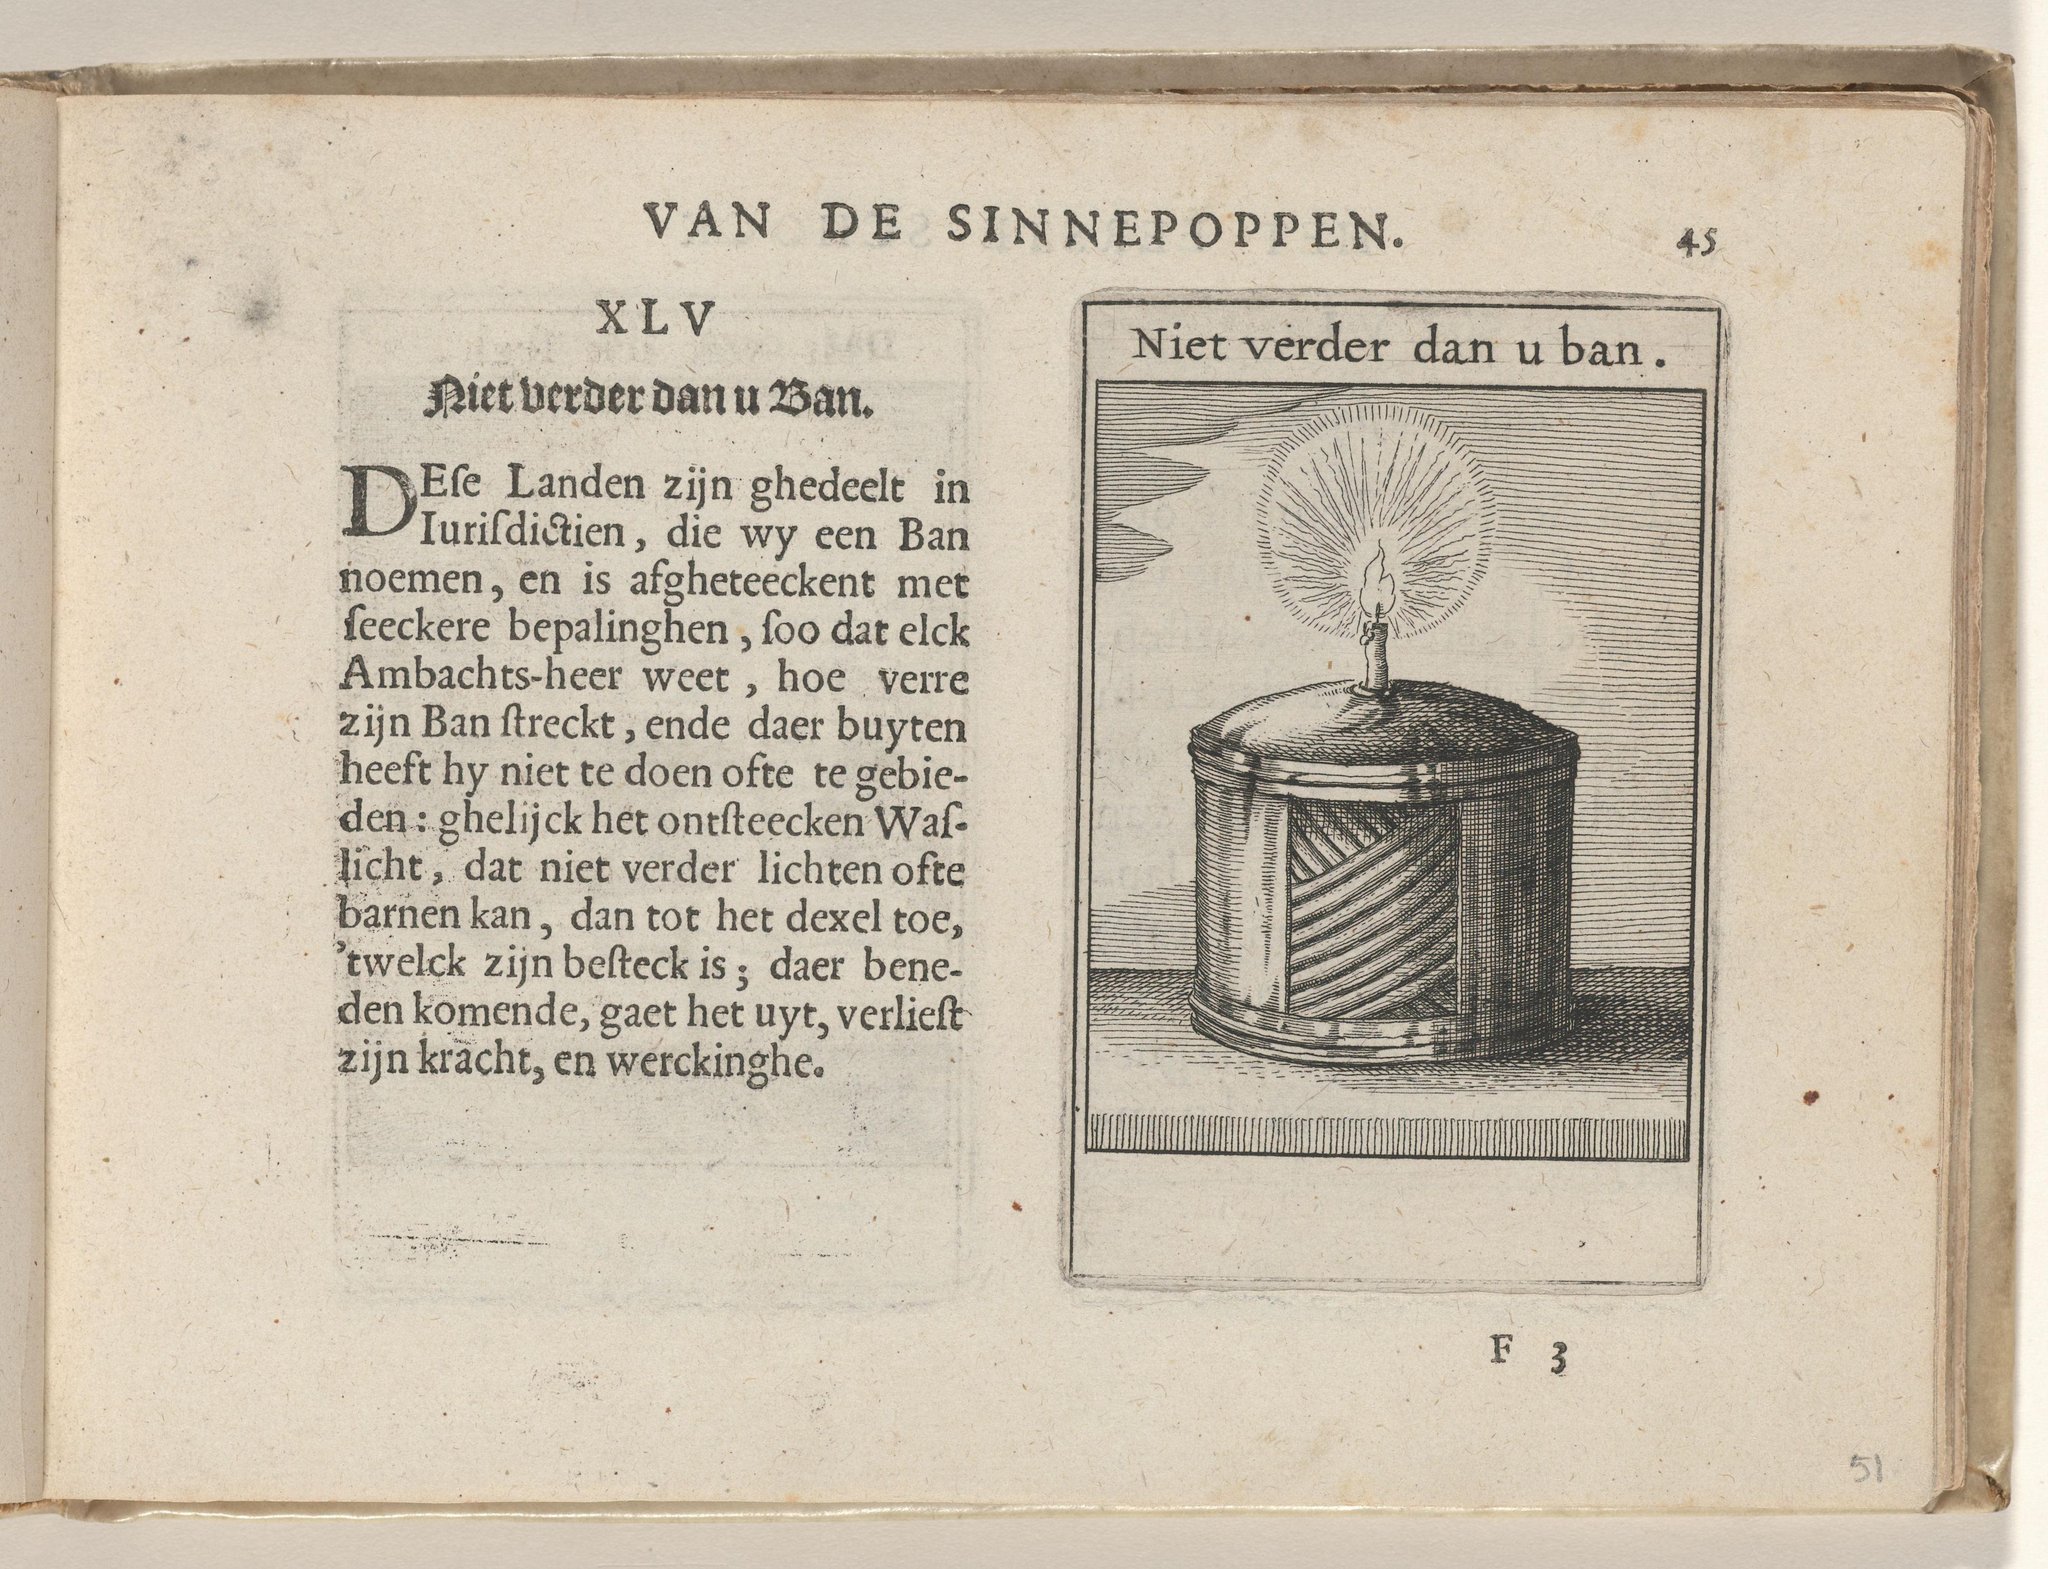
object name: print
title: XLV Niet verder dan u ban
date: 1614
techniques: engraving, printing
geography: the hague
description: XLV Niet verder dan u ban. Eerste schok. Onderdeel van 'Sinnepoppen', R. Visscher, 1614.